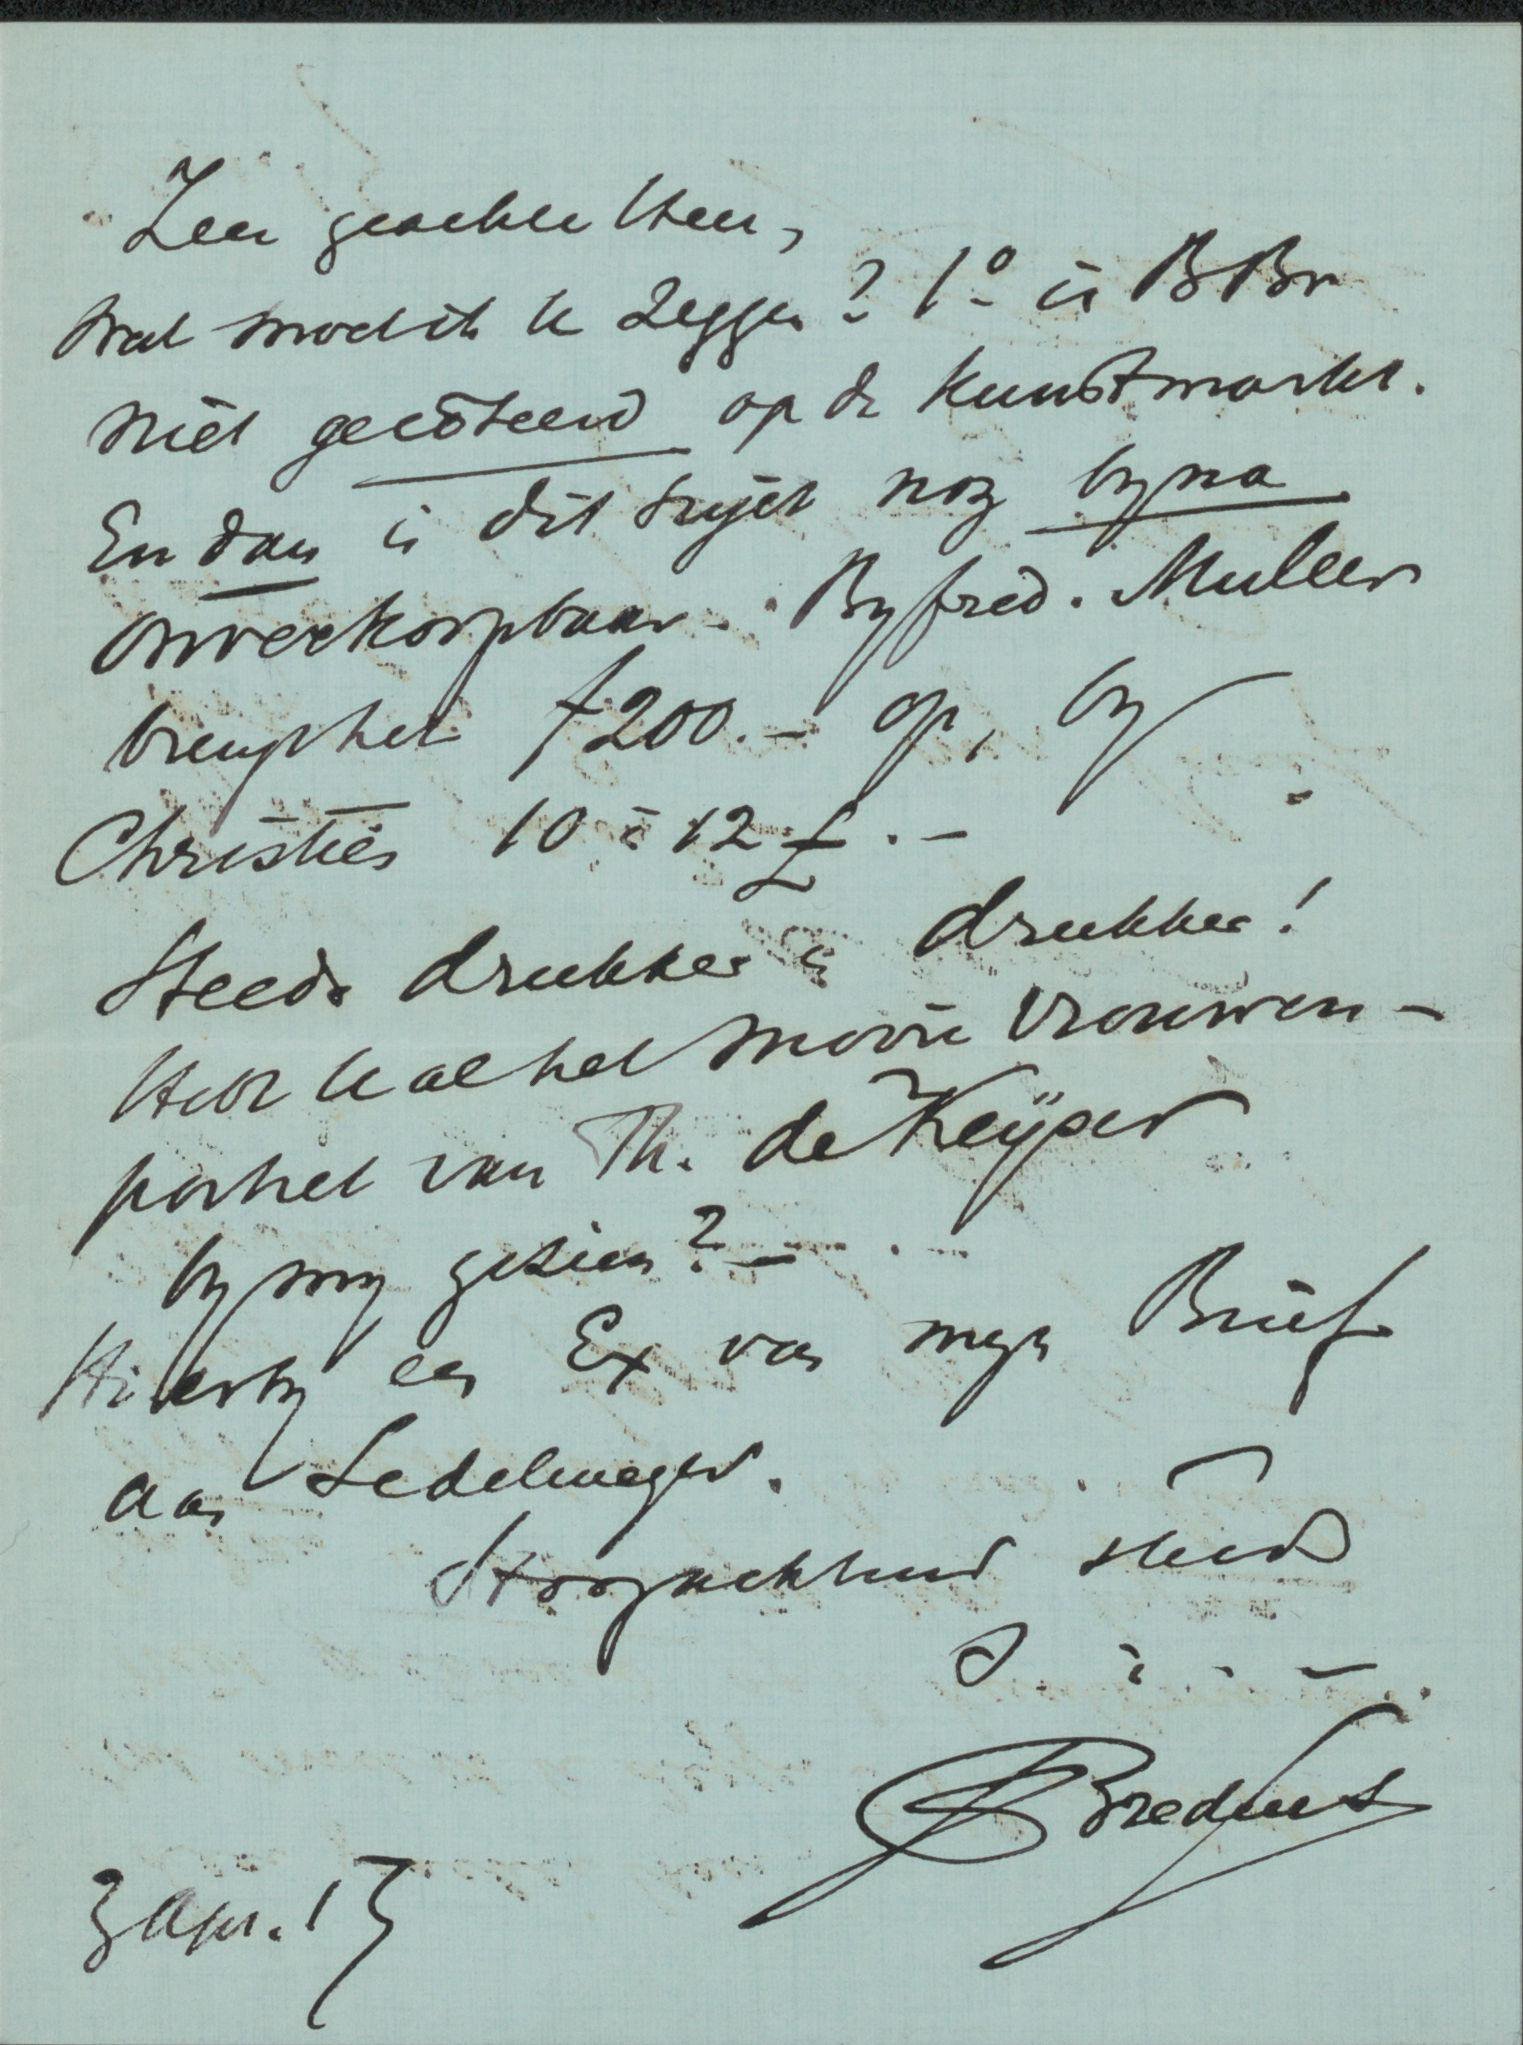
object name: letter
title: Brief aan Philip Zilcken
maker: abraham bredius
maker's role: kunsthistoricus, museumdirecteur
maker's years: 1855-1946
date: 1913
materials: ink, paper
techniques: pen, writing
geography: the hague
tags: amsterdam, thomas de keyser, painter, draughtsman, philip zilcken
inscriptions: collector's mark: ‘RPK’